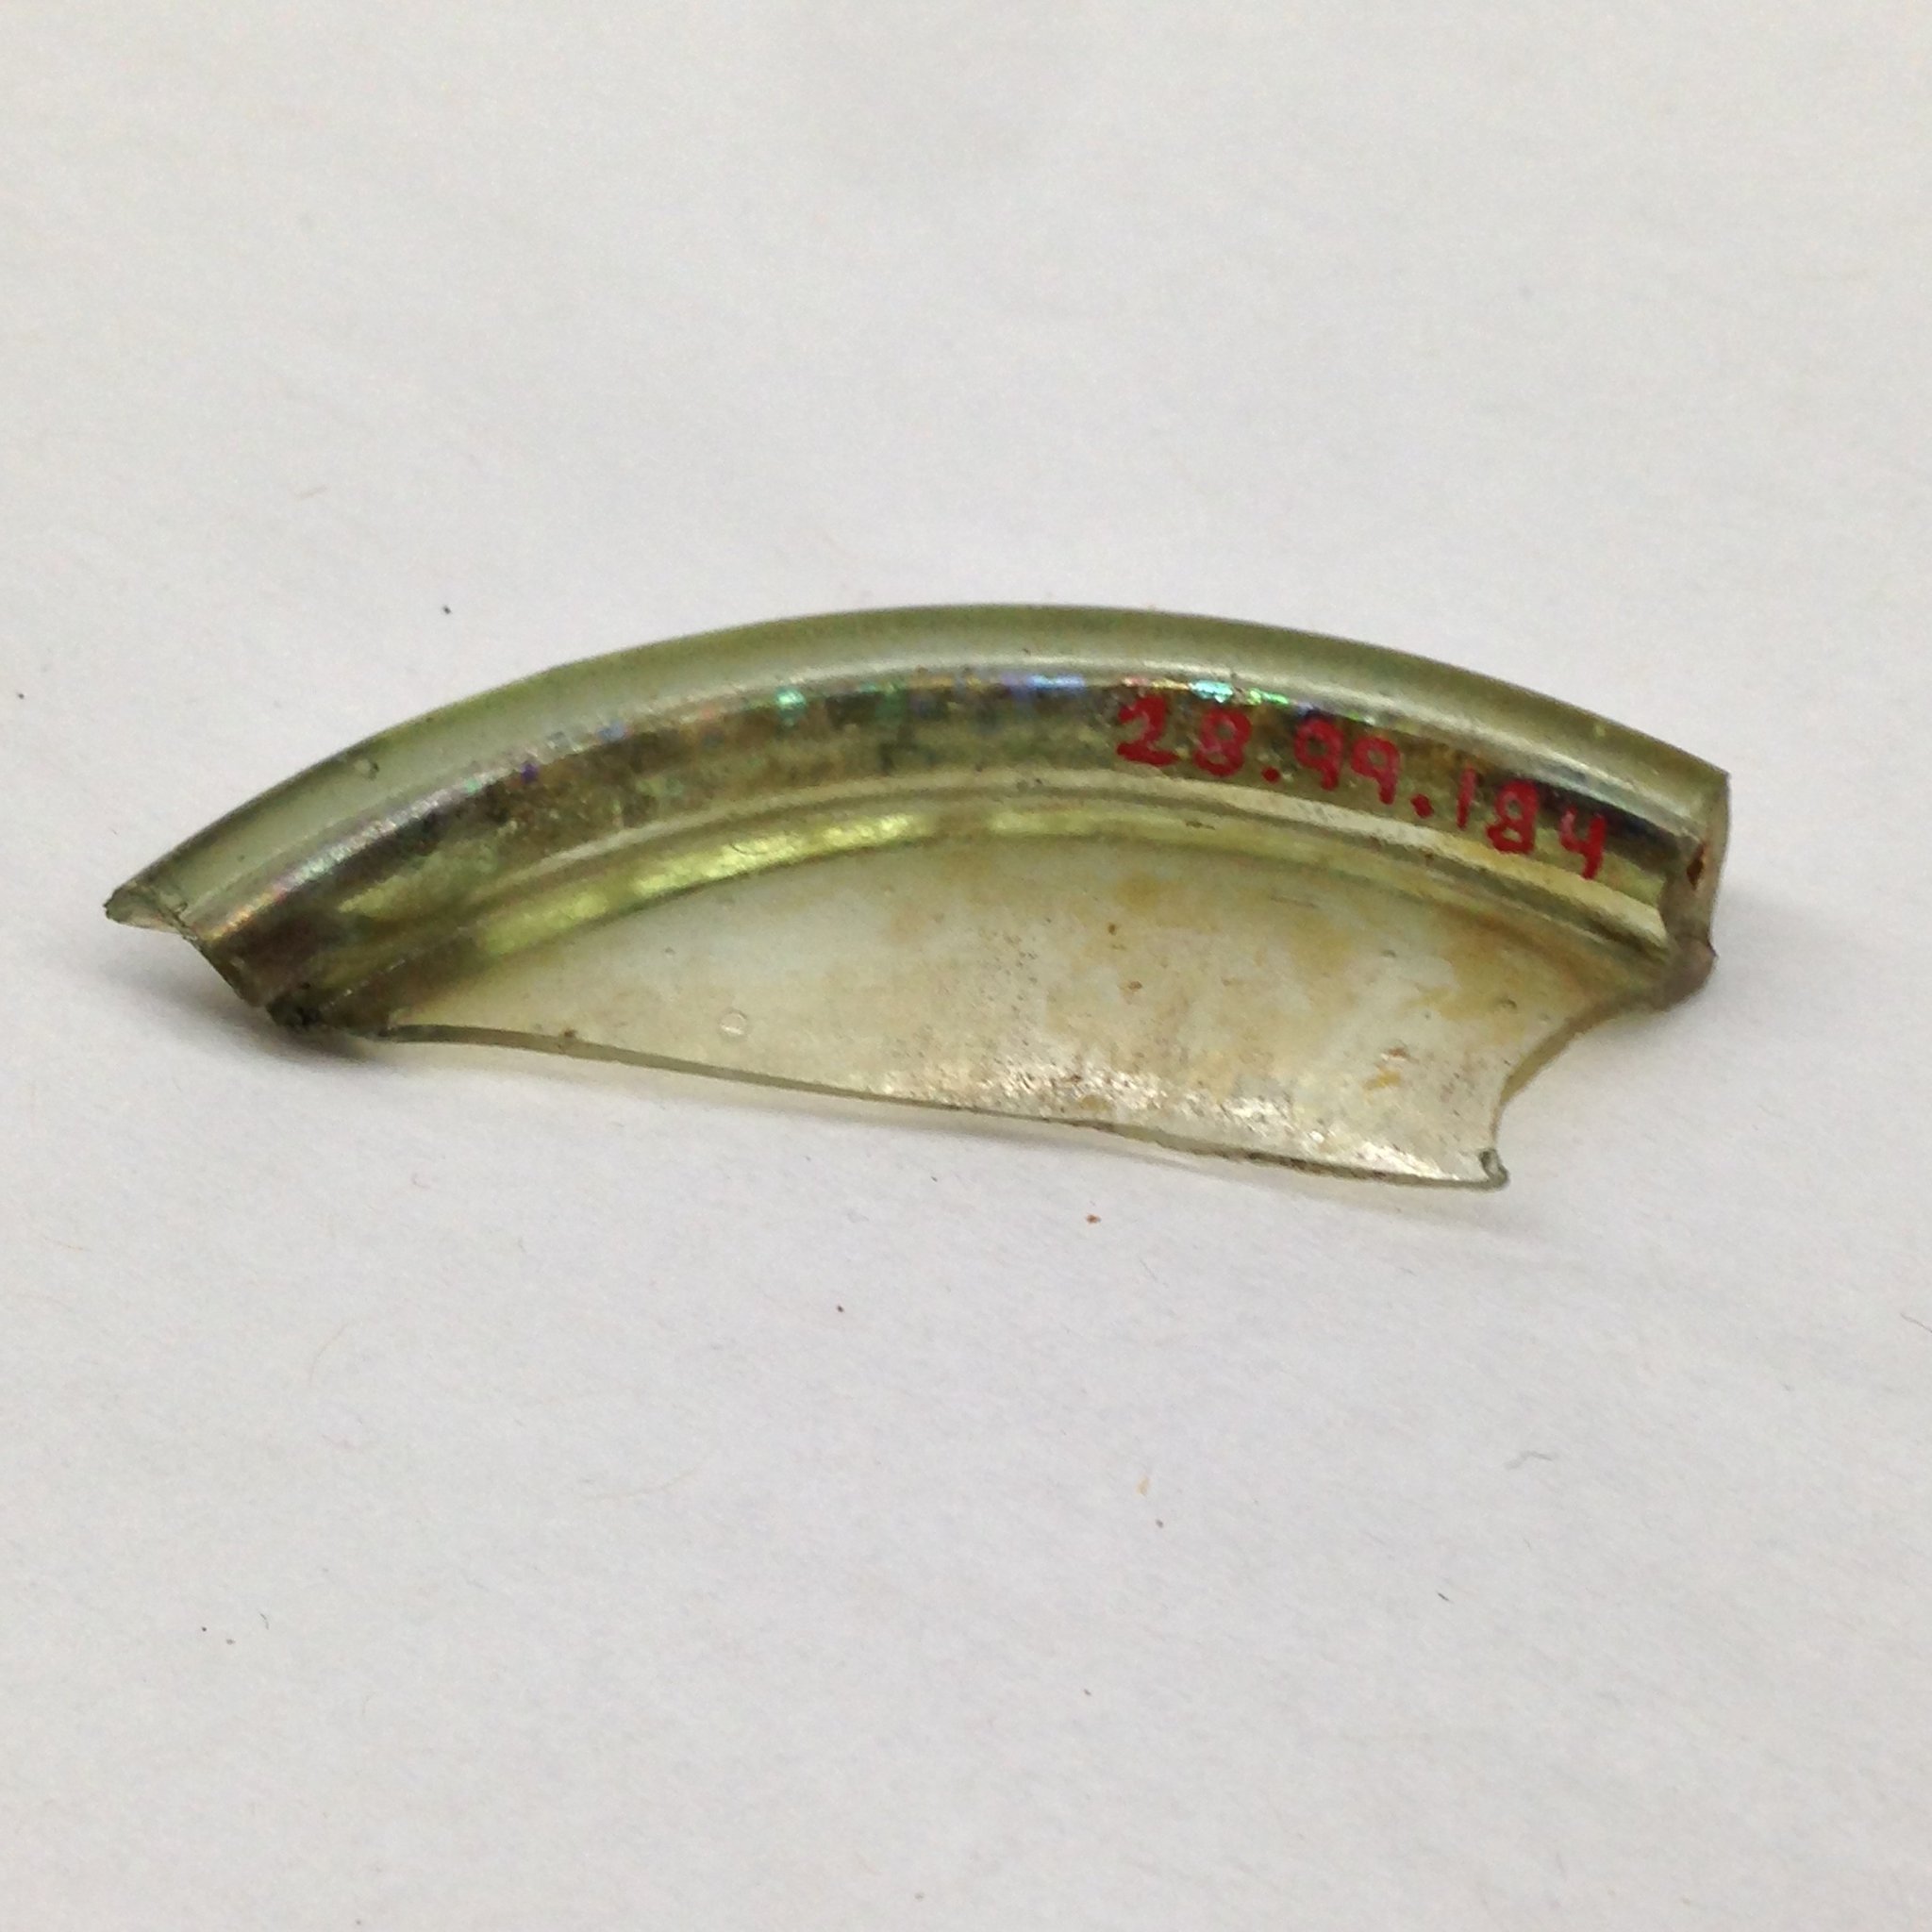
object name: fragment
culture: european or middle eastern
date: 1150-1250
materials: ceramic, glass